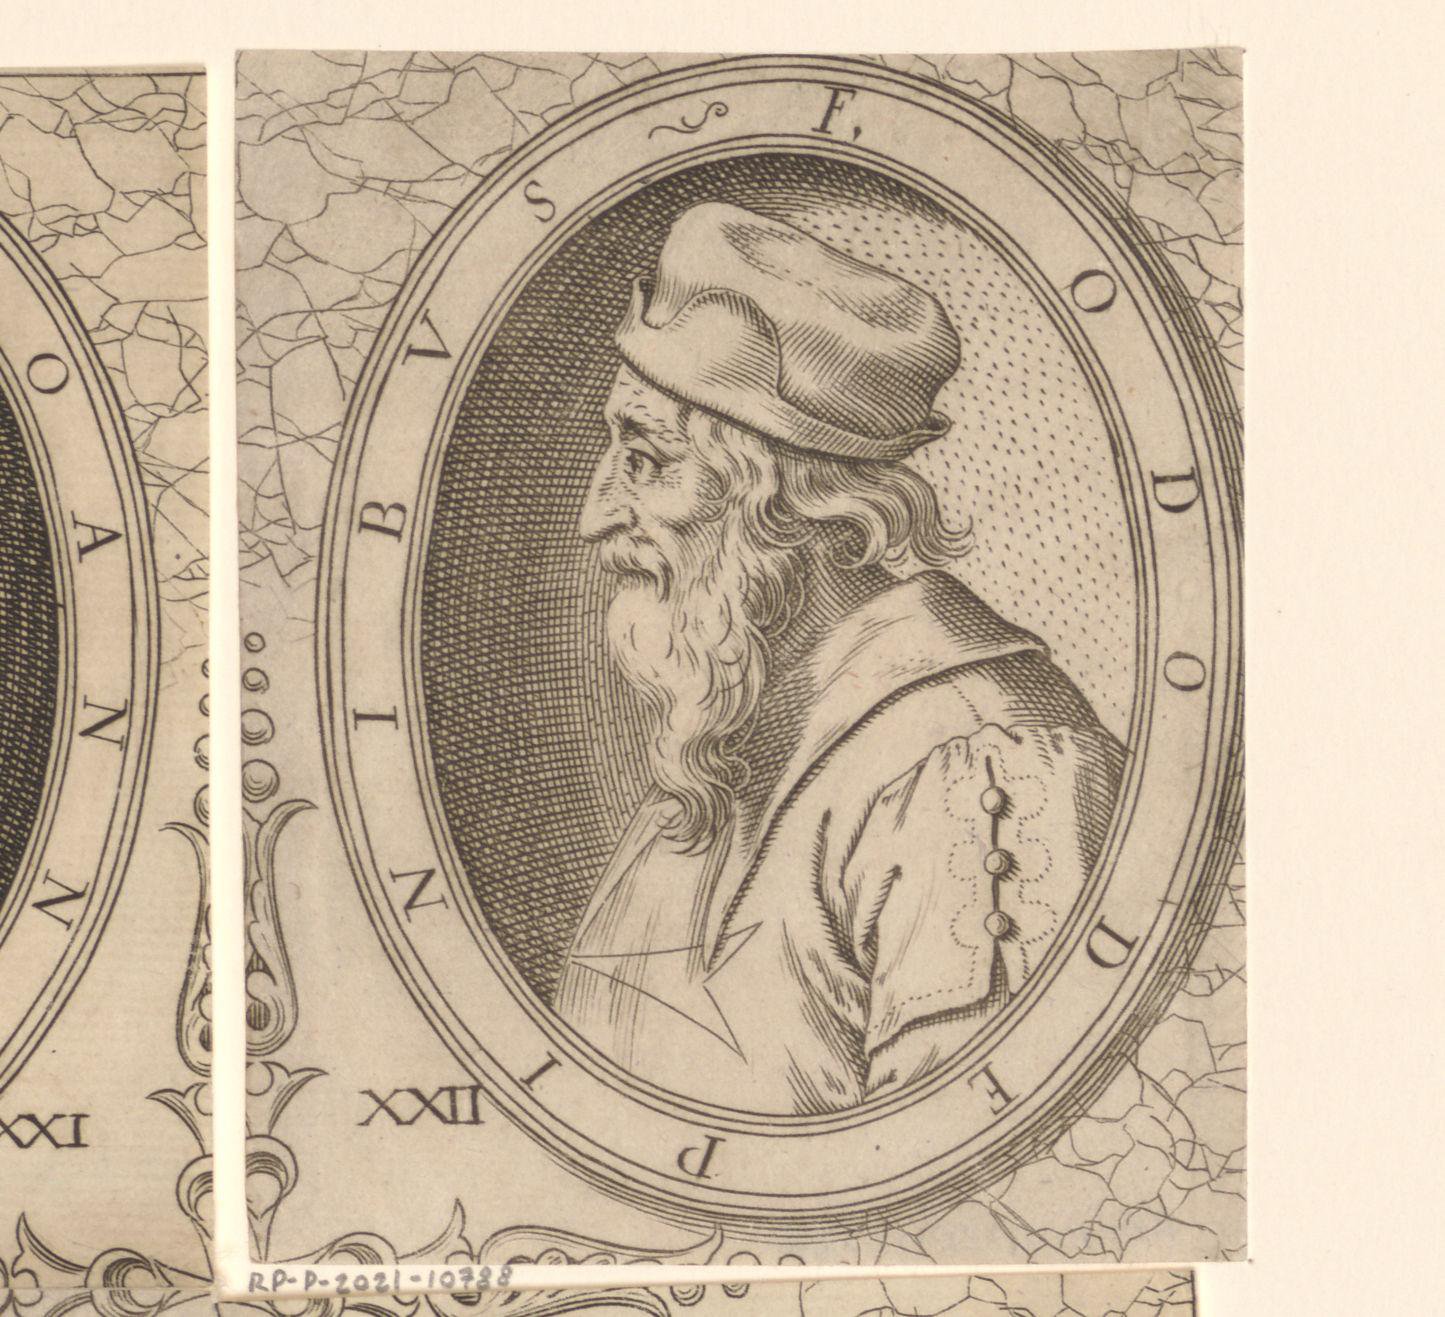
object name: print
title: Portret van Odon de Pins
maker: philippe thomassin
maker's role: print maker, publisher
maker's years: 1562-1622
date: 1588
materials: paper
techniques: engraving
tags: historical persons, military orders, e.g.: knights templars, knights of malta, teutonic knights ~ roman catholic church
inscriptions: collector's mark: Lugt 2228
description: Deze prent maakt deel uit van een grotere prent met vier portretten die later is verknipt. Prent waarschijnlijk uit: Veltroni, Tolomeo. Statuta hospitalis Hierusalem. [Rome: s.n., 1588].